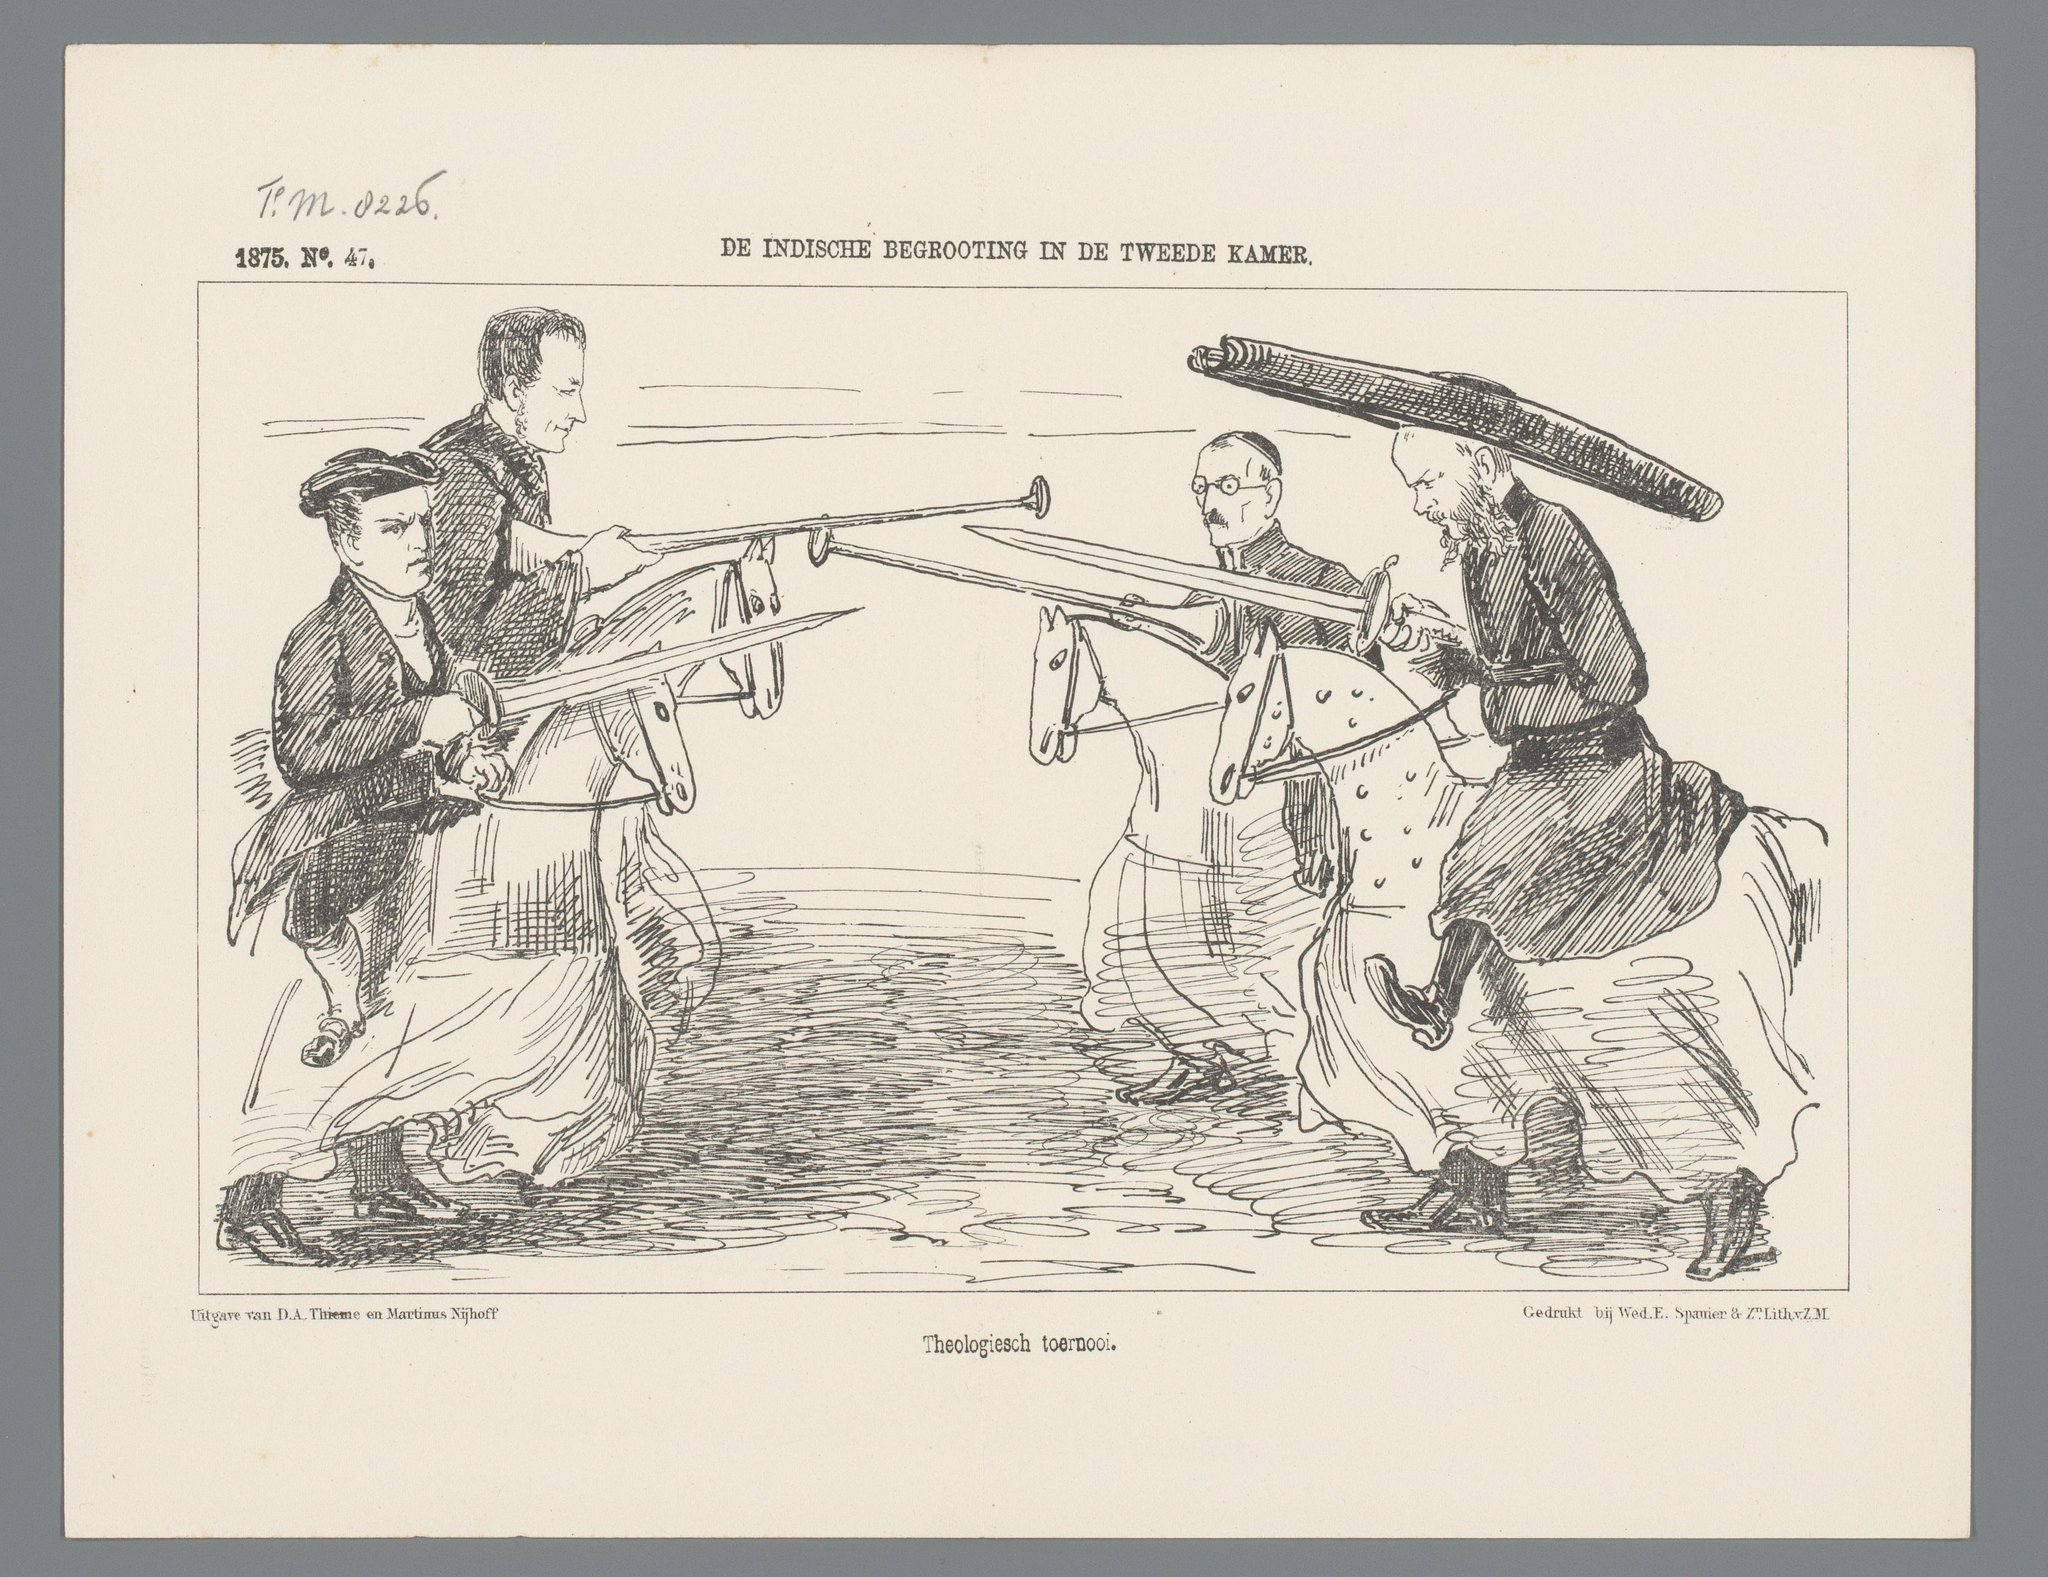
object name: cartoon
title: Spotprent op het christelijke onderwijs in Nederlands-Indië, 1875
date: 1875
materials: paper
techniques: lithograph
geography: arnhem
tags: dutch east indies, the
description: Spotprent op de debatten over het al dan niet bevorderen van het christelijke onderwijs in de kolonie Nederlands-Indië. Plaat verschenen bij het weekblad De Nederlandsche Spectator, nr. 47, 1875.